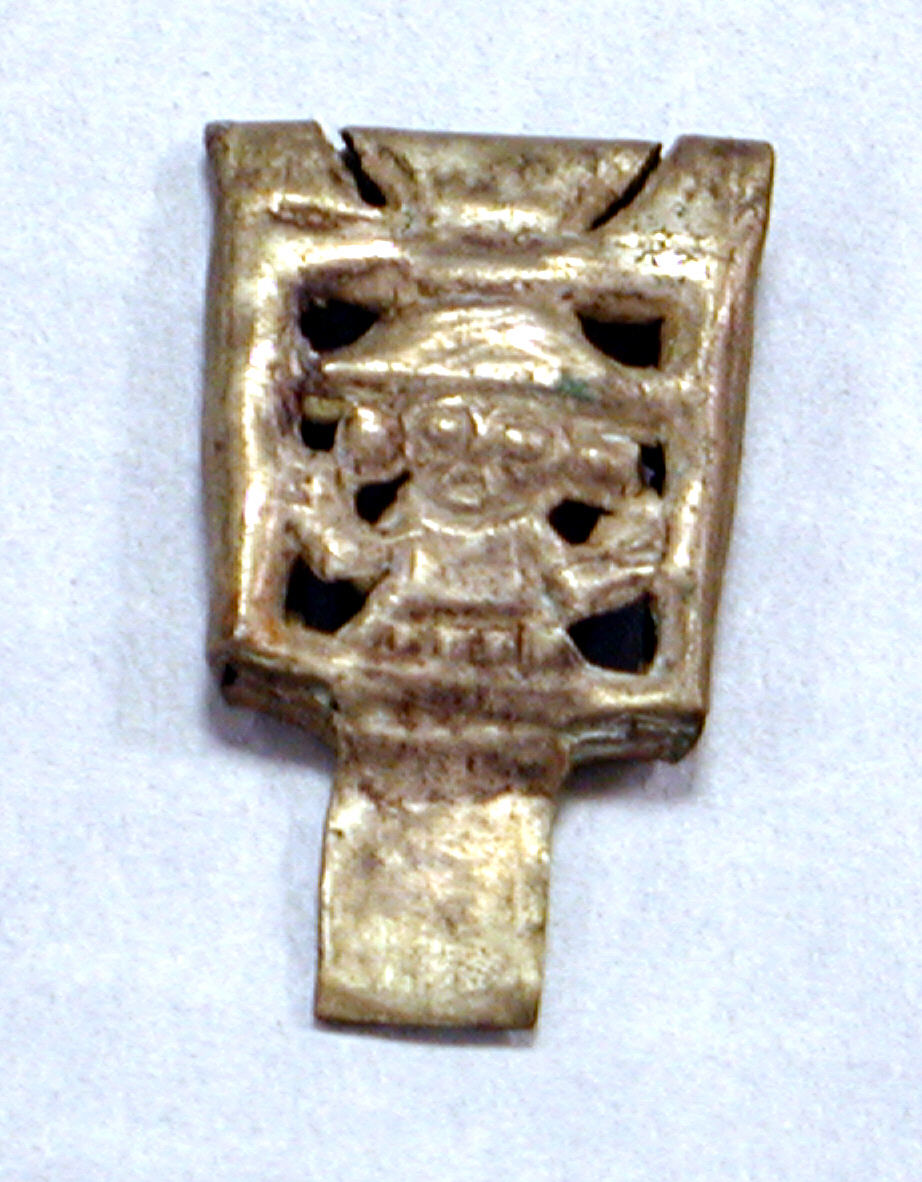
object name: mirror back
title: Hammered Silver Mirror Back (?)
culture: peruvian, north or central coast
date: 1001-1566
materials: gilt, silver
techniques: hammering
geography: peru